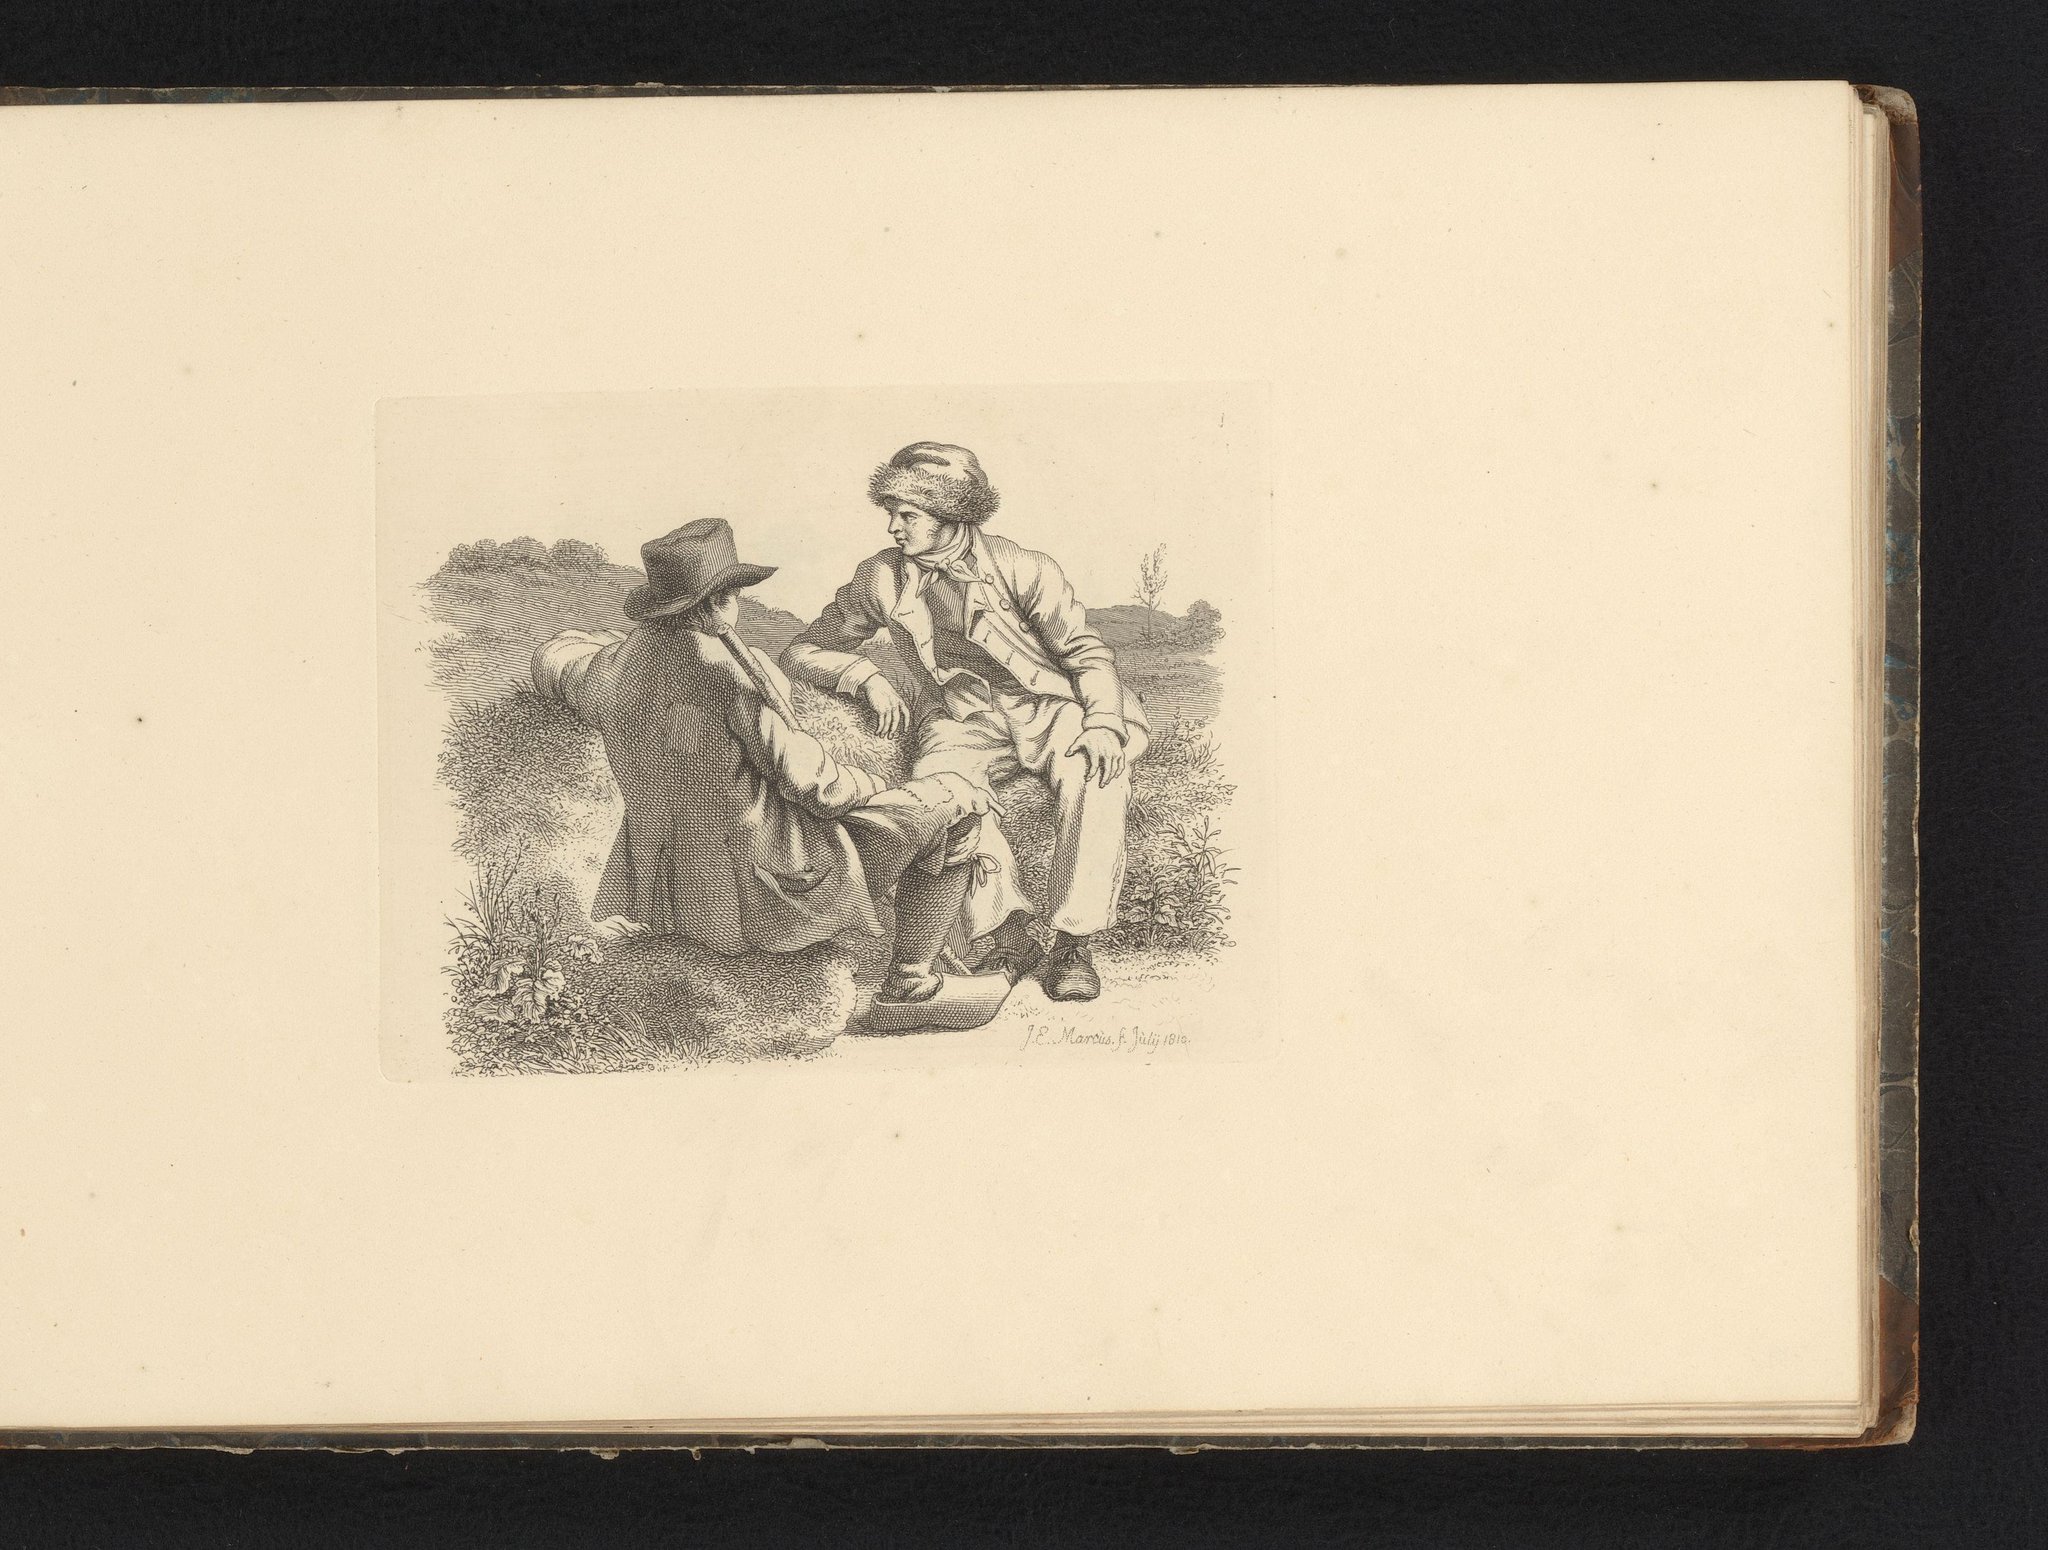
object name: album leaf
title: Landschap met twee zittende mannen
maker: jacob ernst marcus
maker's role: draughtsman, print maker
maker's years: 1774-1826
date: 1807-1810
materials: paper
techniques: etching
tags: adult man, sitting on an elevation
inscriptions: date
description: Deze prent maakt deel uit van een album.